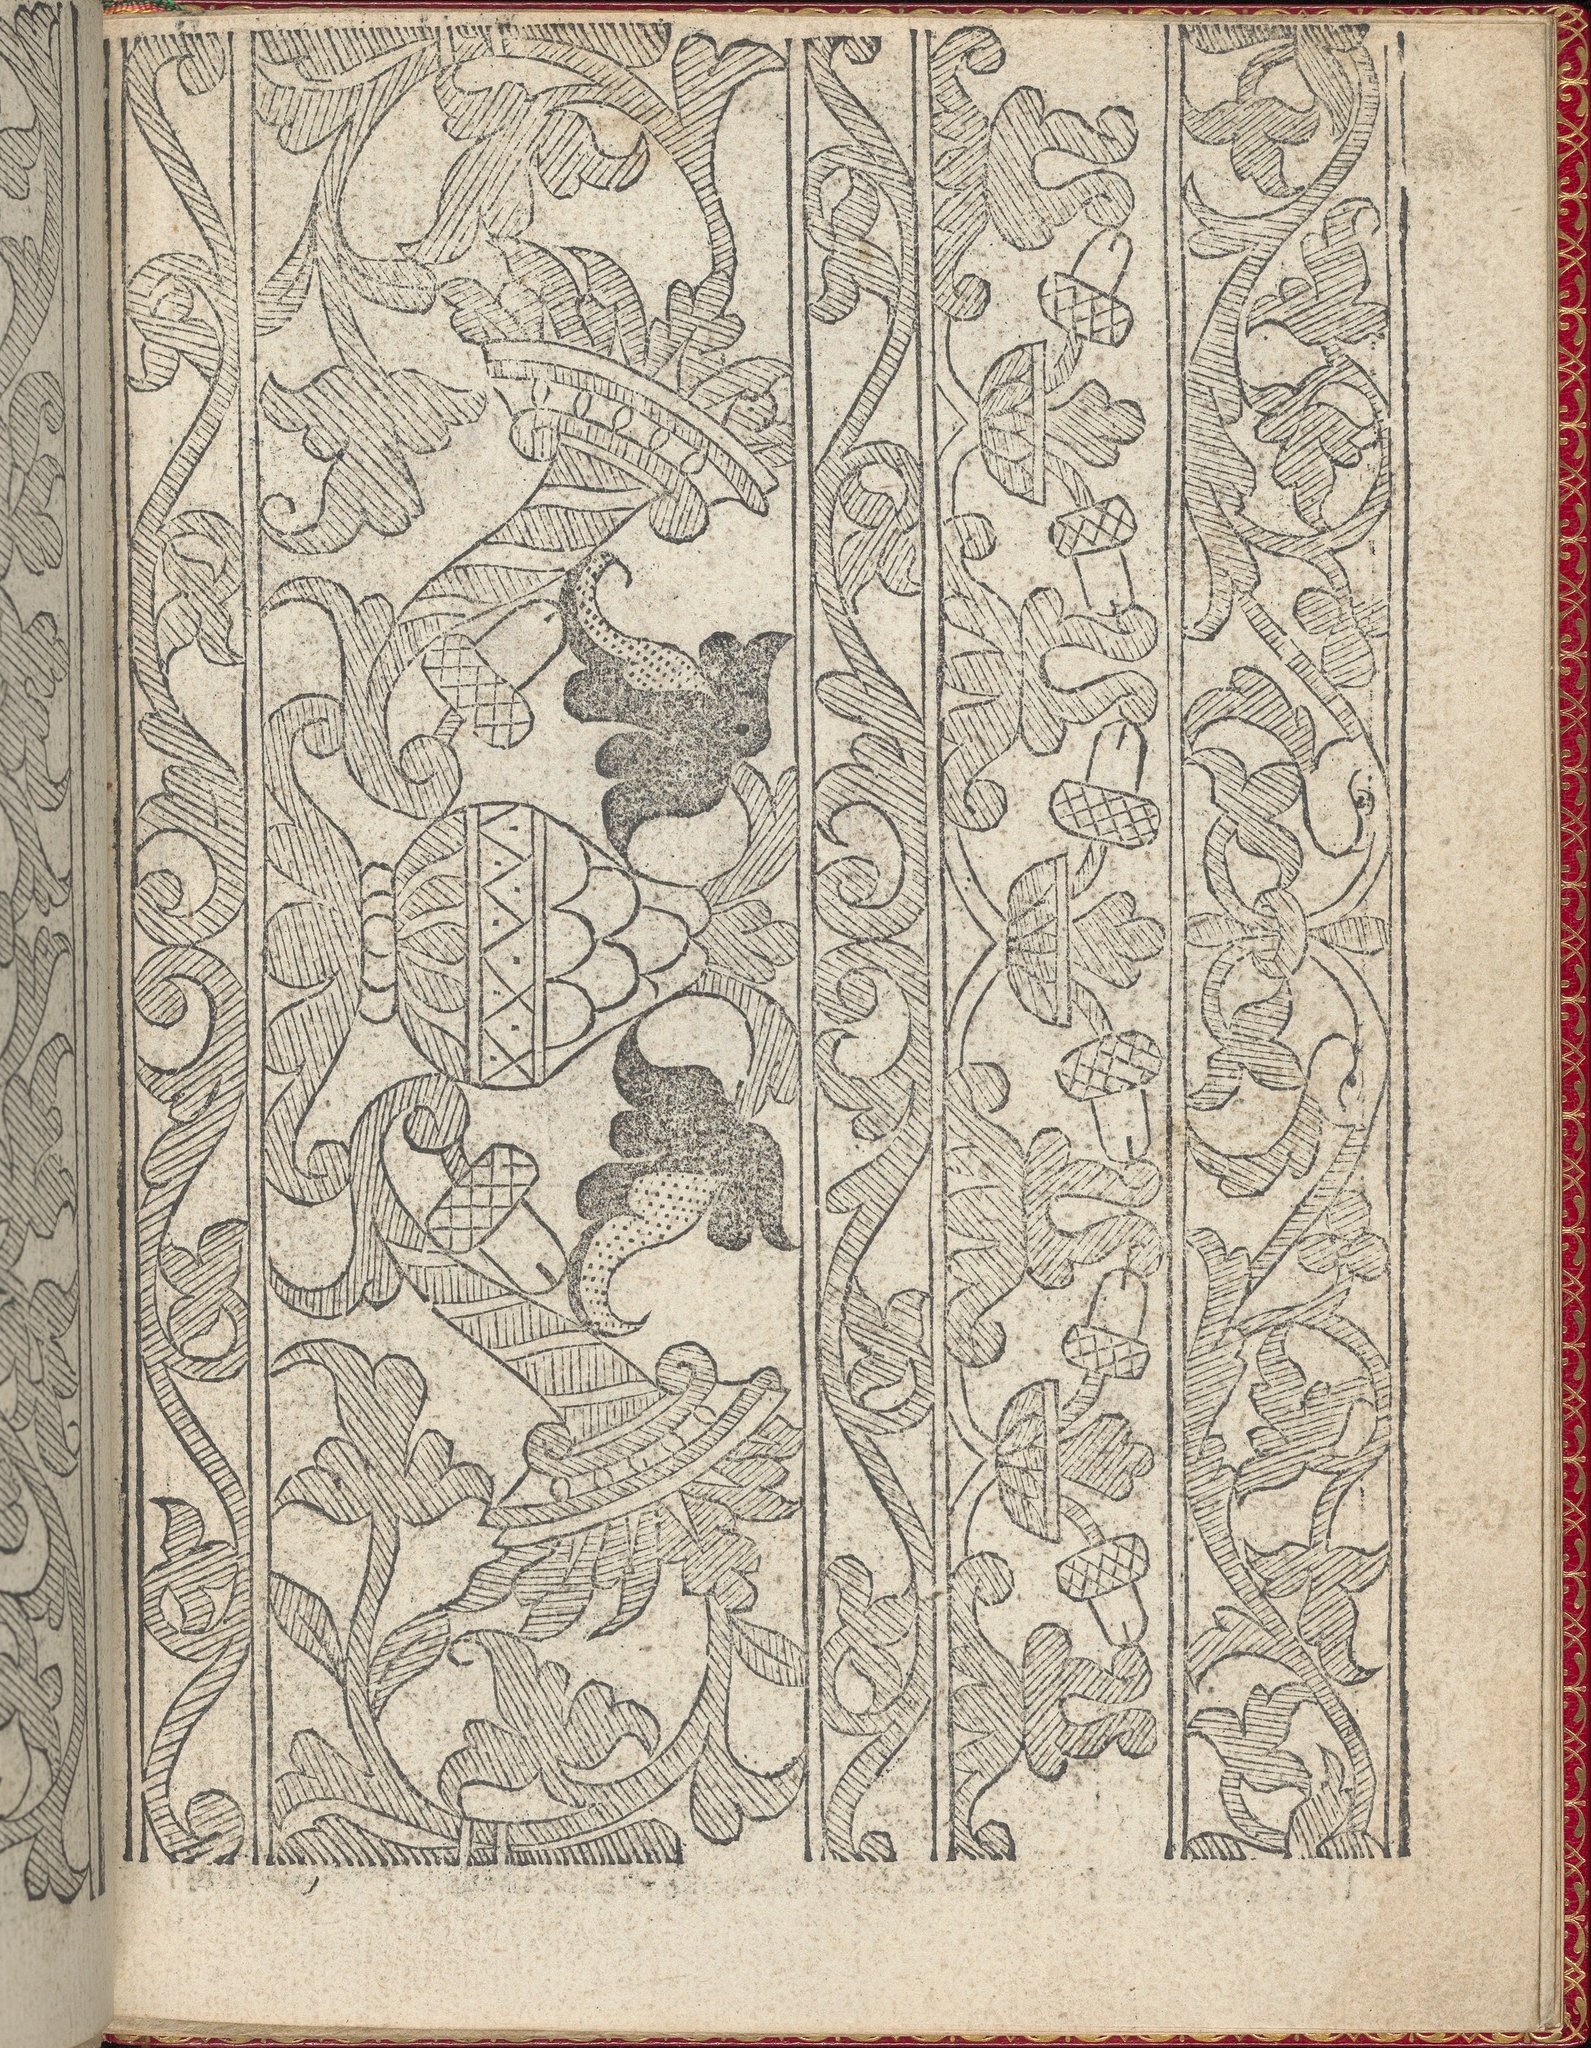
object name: book print ornament architecture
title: Il Monte. Opera Nova di Recami, page 4 (recto)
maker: giovanni antonio bindoni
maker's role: designer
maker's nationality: italian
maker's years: 1500-1650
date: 1557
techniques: woodcut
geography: italy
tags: cornucopia,flowers,leaves,vines,vases